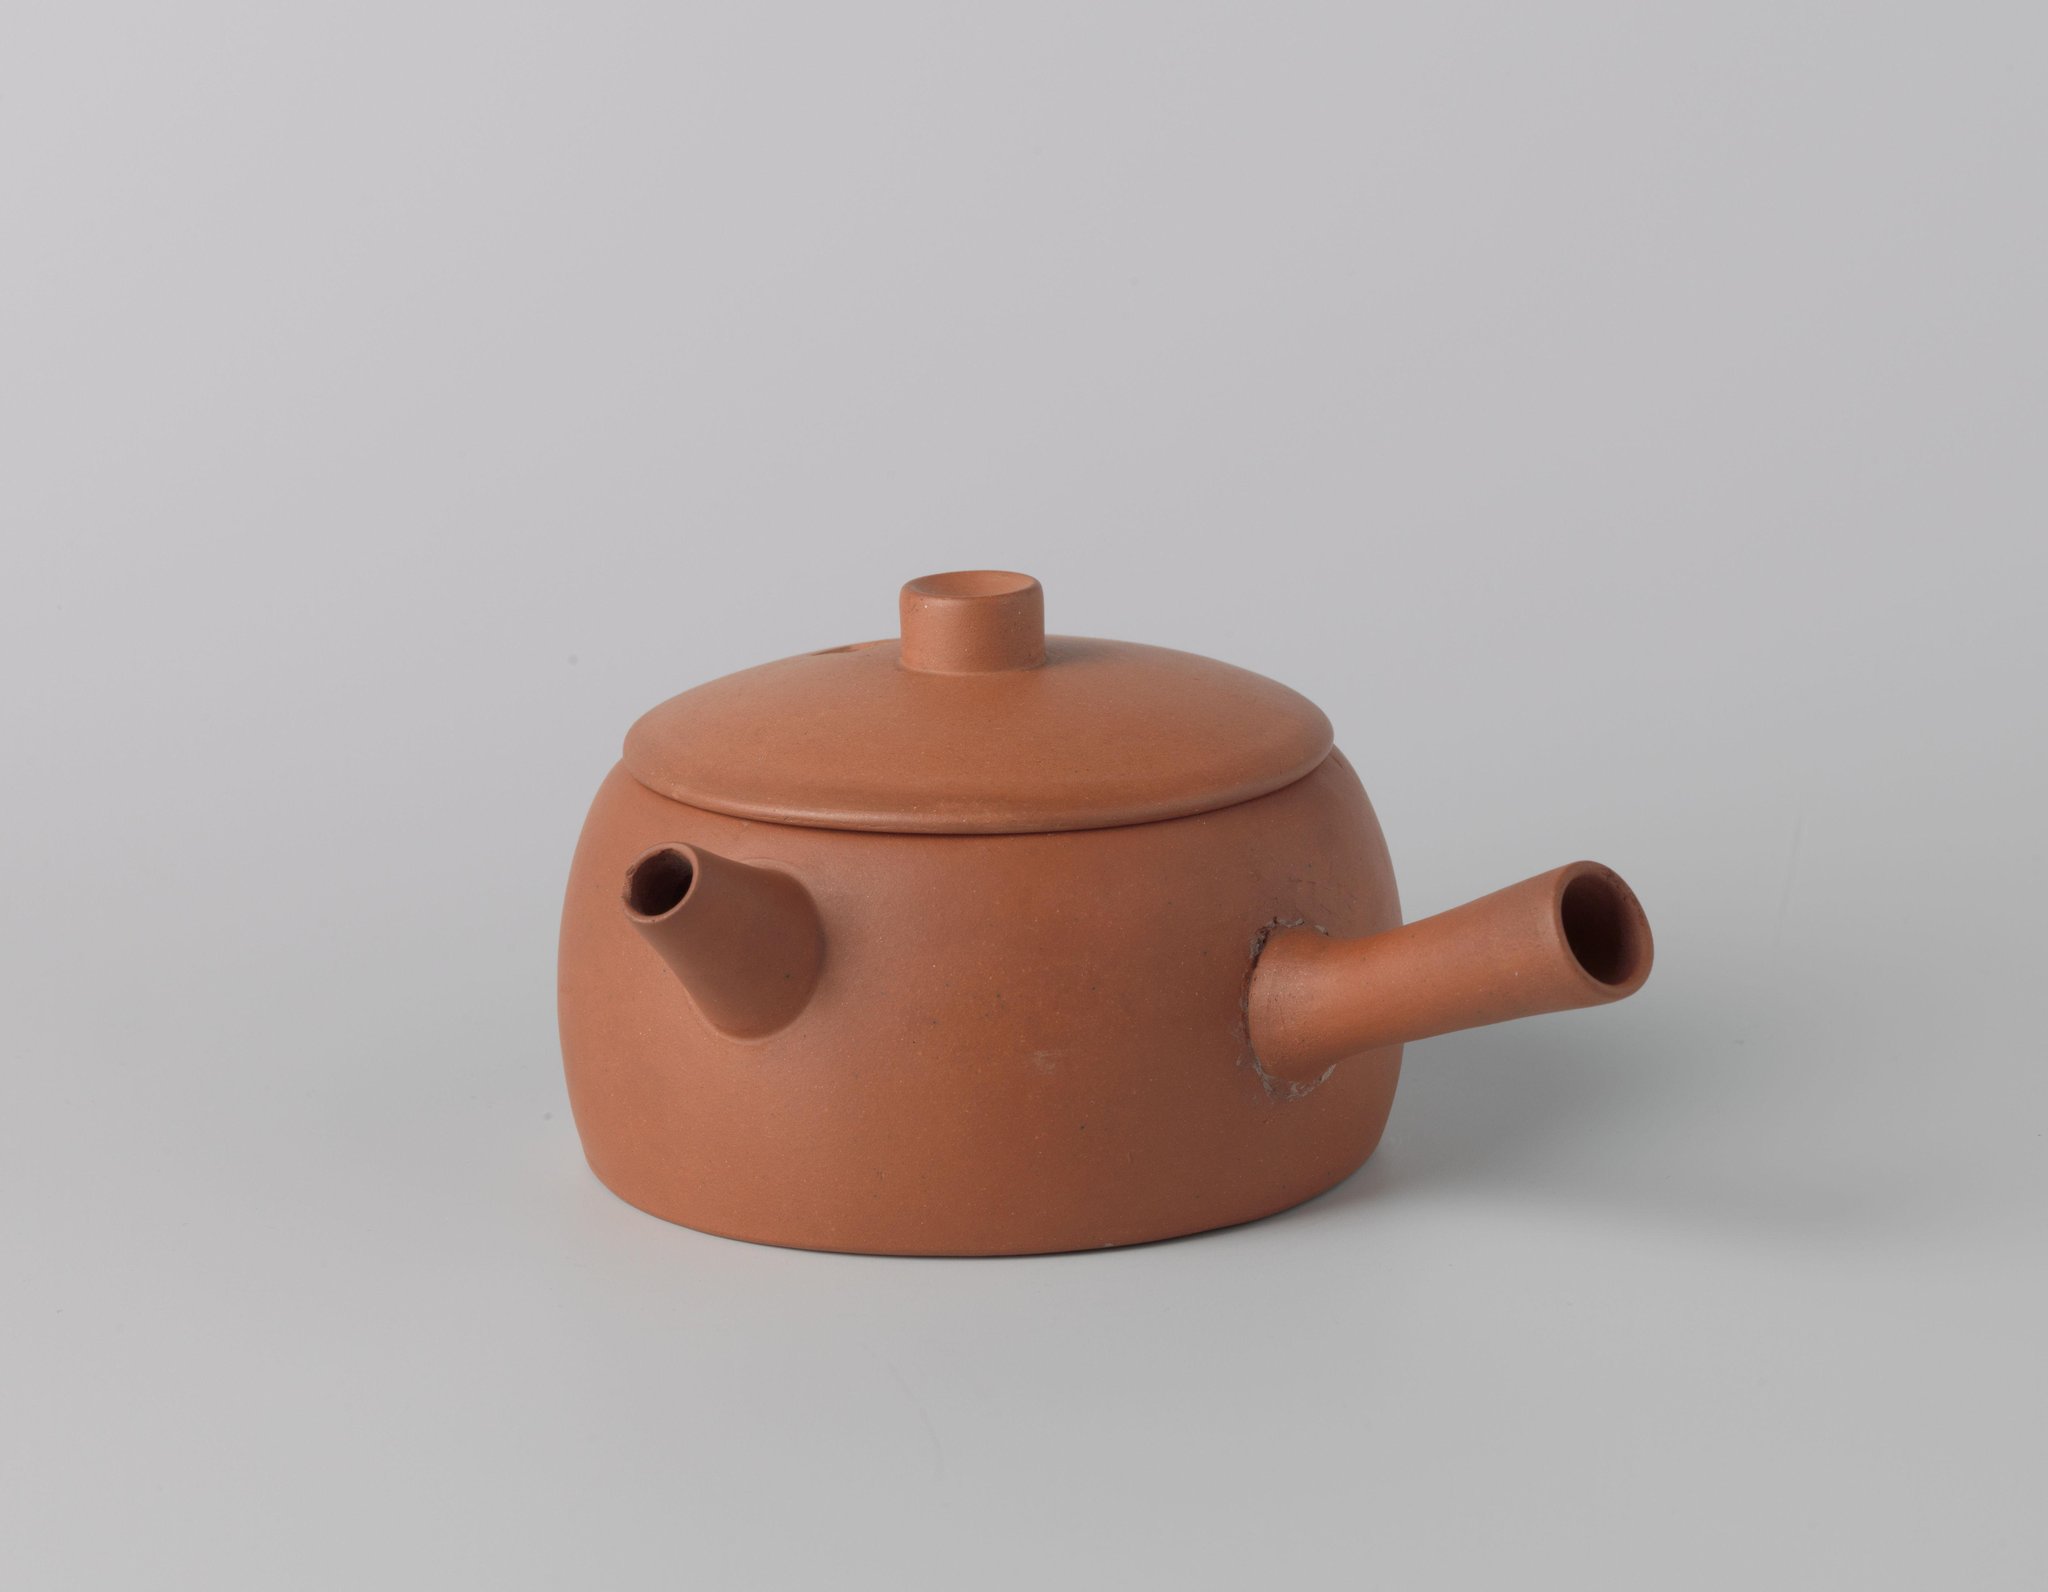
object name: teapot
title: Tea pot of red stoneware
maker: Anonymous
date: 1800-1824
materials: stoneware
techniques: firing, forming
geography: japan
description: During the Edo Period (1603-1868), Yixing teapots were traded in Japan, where they were also imitated. In the 19th century, kilns in the Japanese city of Tokoname were producing large quantities of imitation Yixing teapots. This particular teapot is used for the Japanese green tea ceremony, known as sencha, which employs a pot characterized by its drum-shaped body and a short spout and handle.